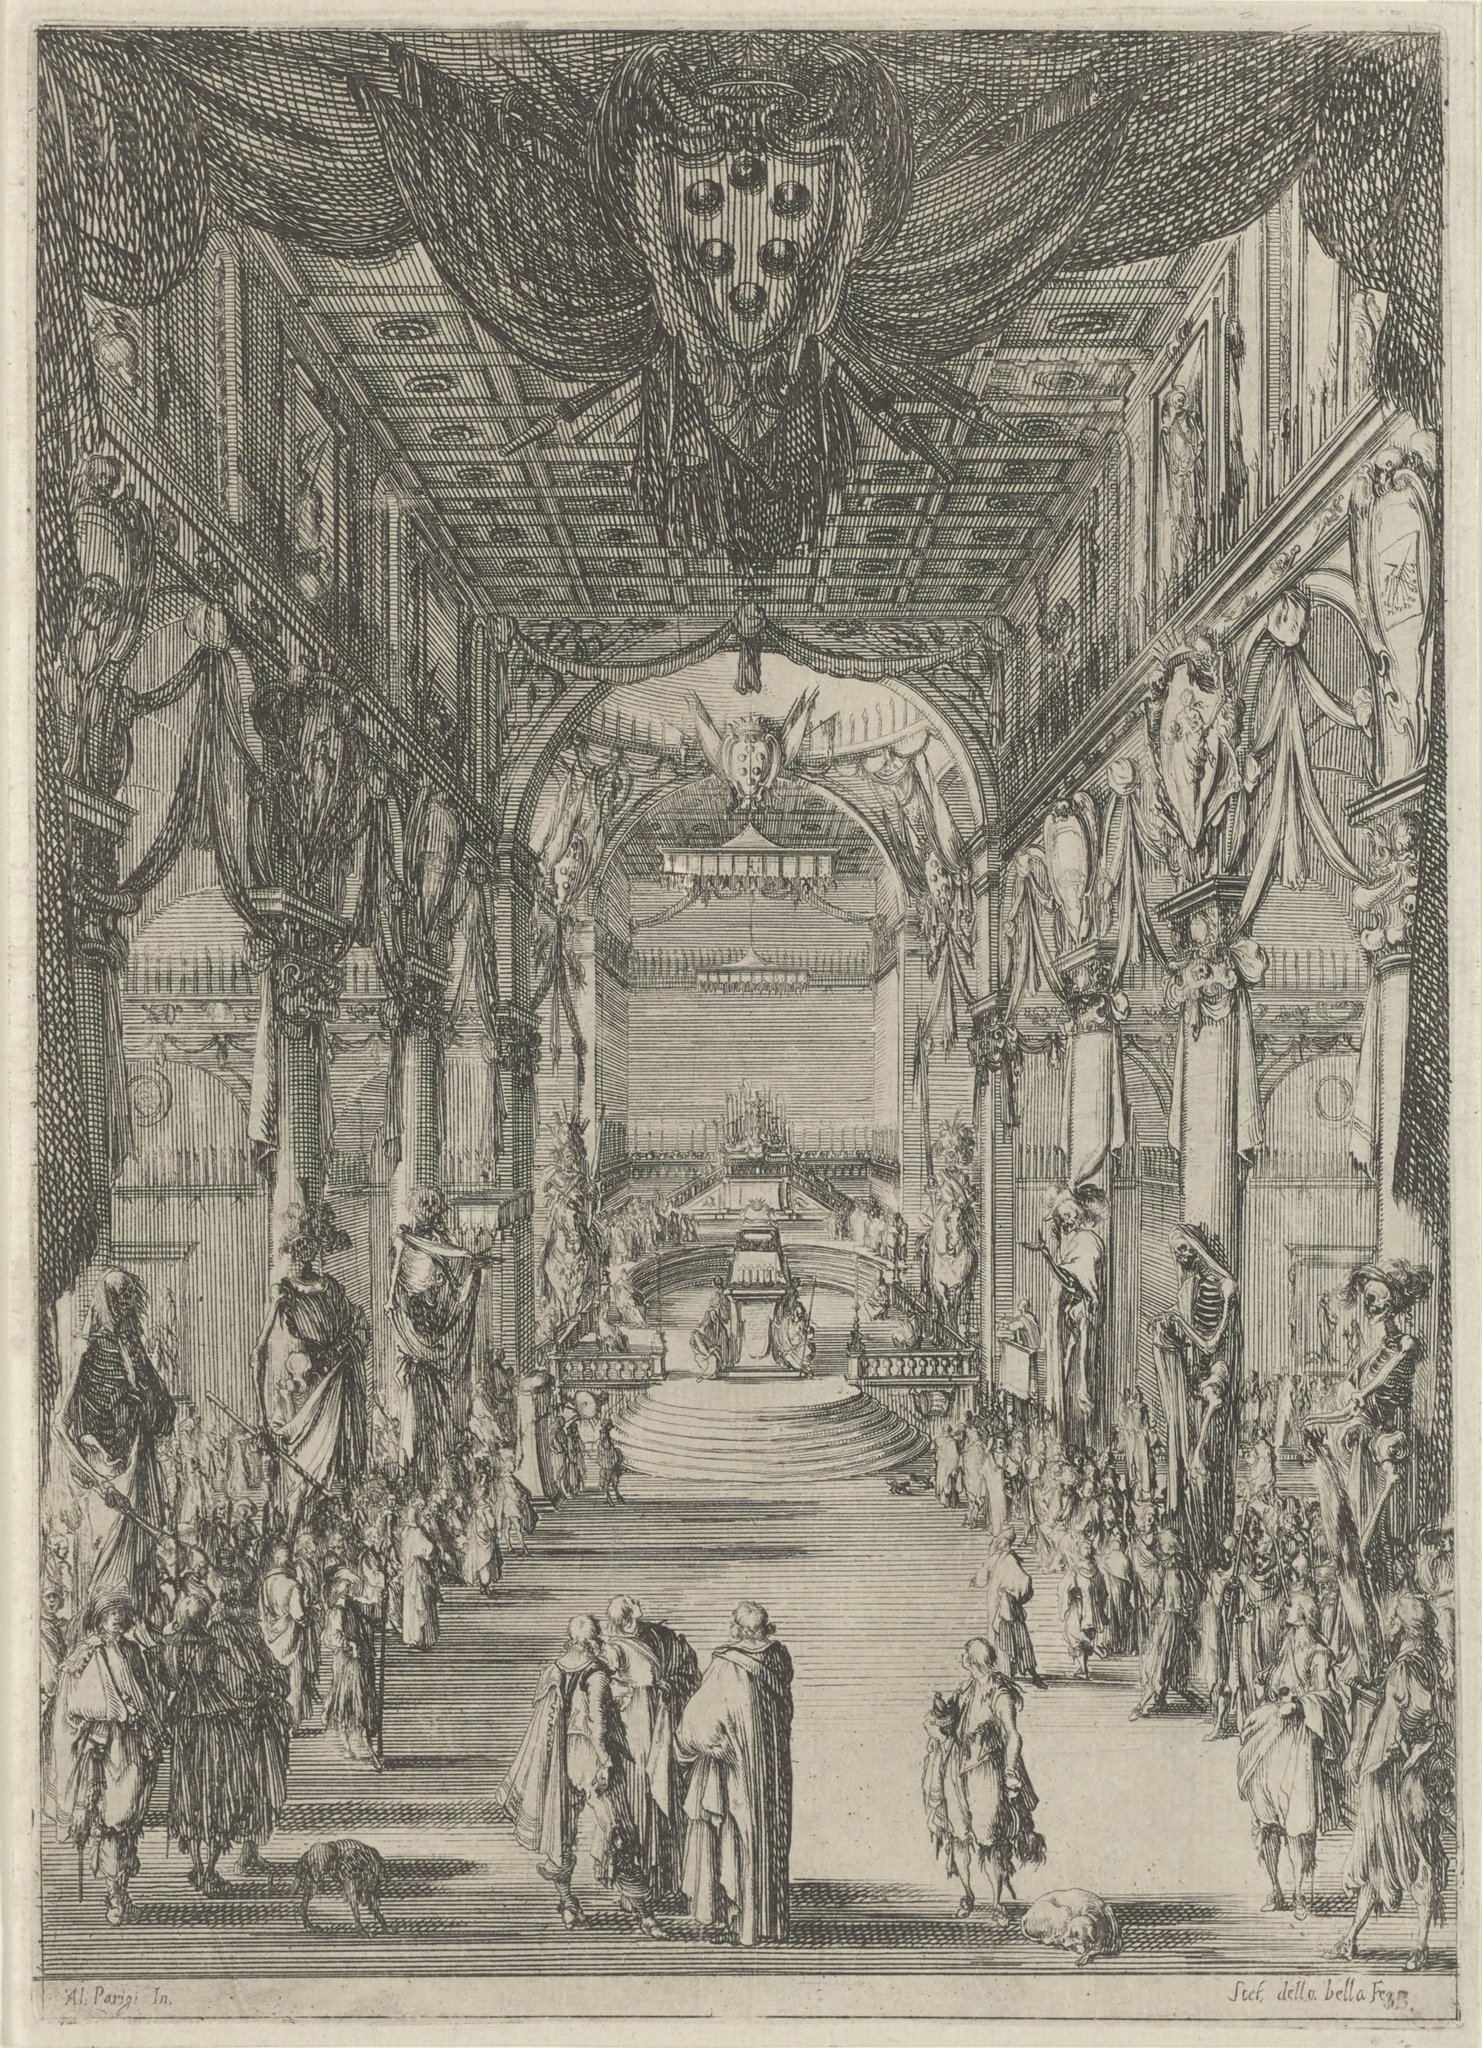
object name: ornament print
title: Begrafenis van Francesco II de' Medici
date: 1620-1664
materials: paper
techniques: etching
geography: italy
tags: funerary ceremonial, public funeral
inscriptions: collector's mark: Lugt 240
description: De begrafenis van Francesco II de' Medici in de San Lorenzo in Florence. Aan het plafond een groot wapenschild de familie de' Medici. Langs het schip zijn verschillende aangeklede skeletten tegen pilaren geplaatst ter decoratie.